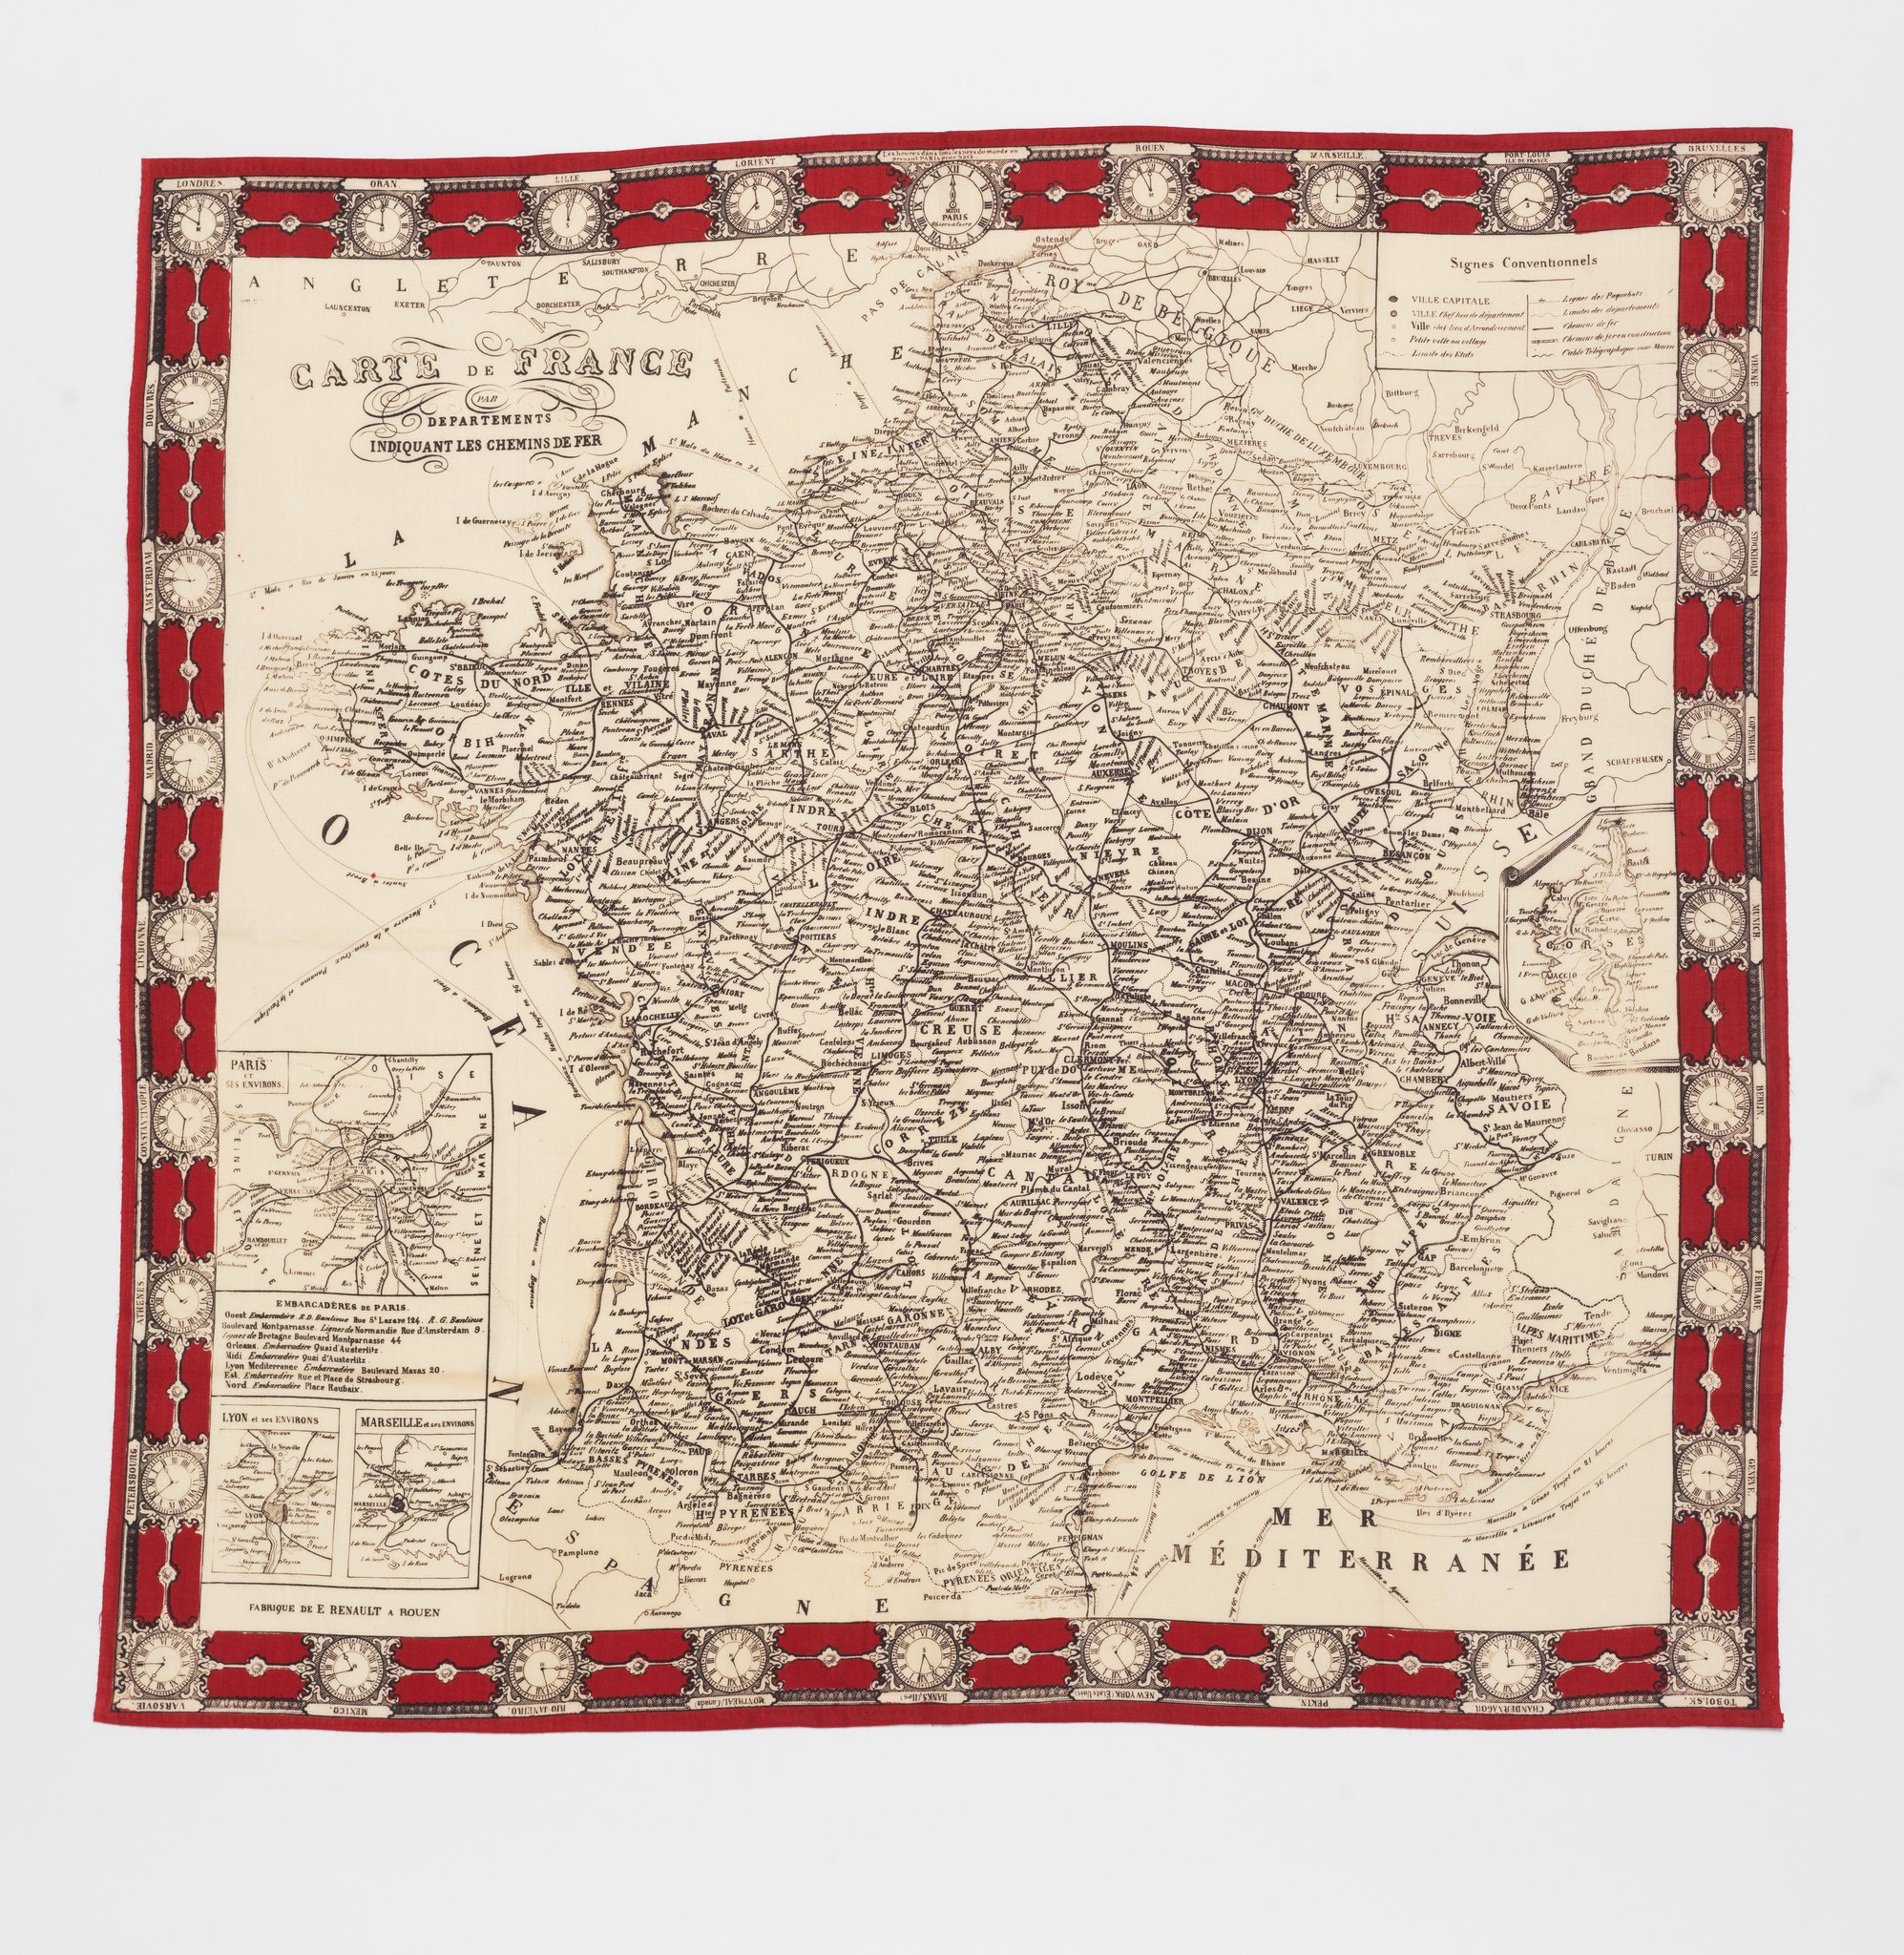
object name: handkerchief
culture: french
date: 1834-1866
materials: cotton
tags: maps